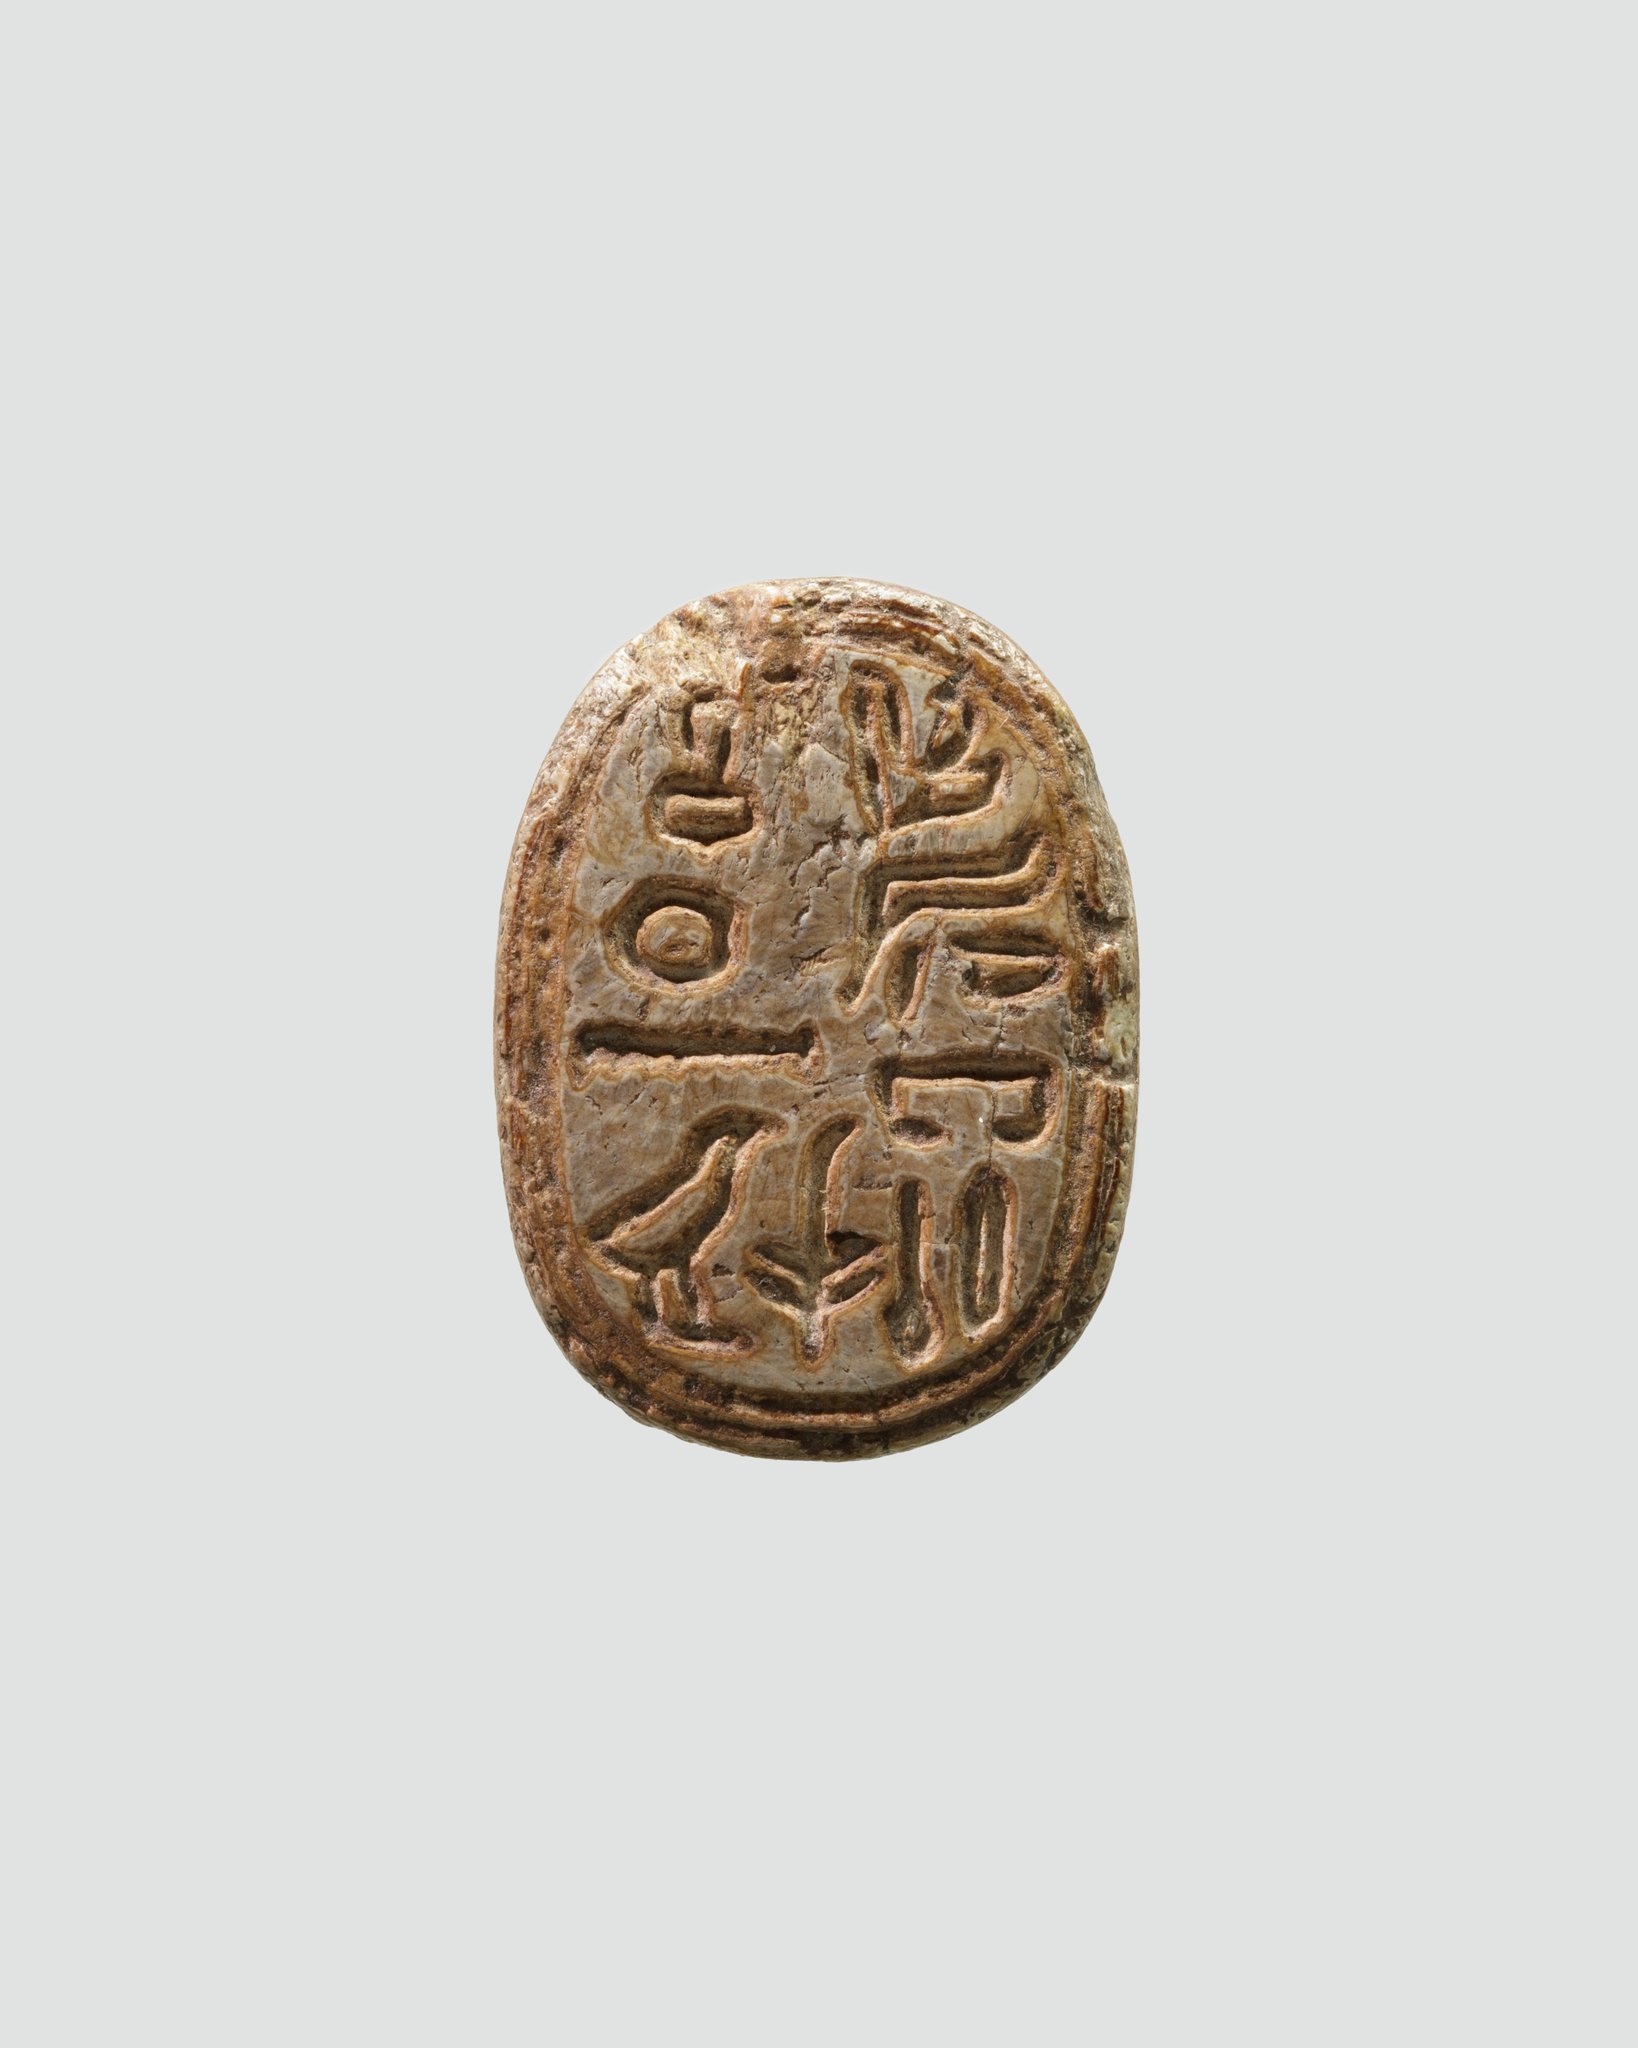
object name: scarab, private name and title, khonsu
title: Scarab of an Official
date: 1760-1670 BCE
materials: stone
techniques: glazing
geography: egypt